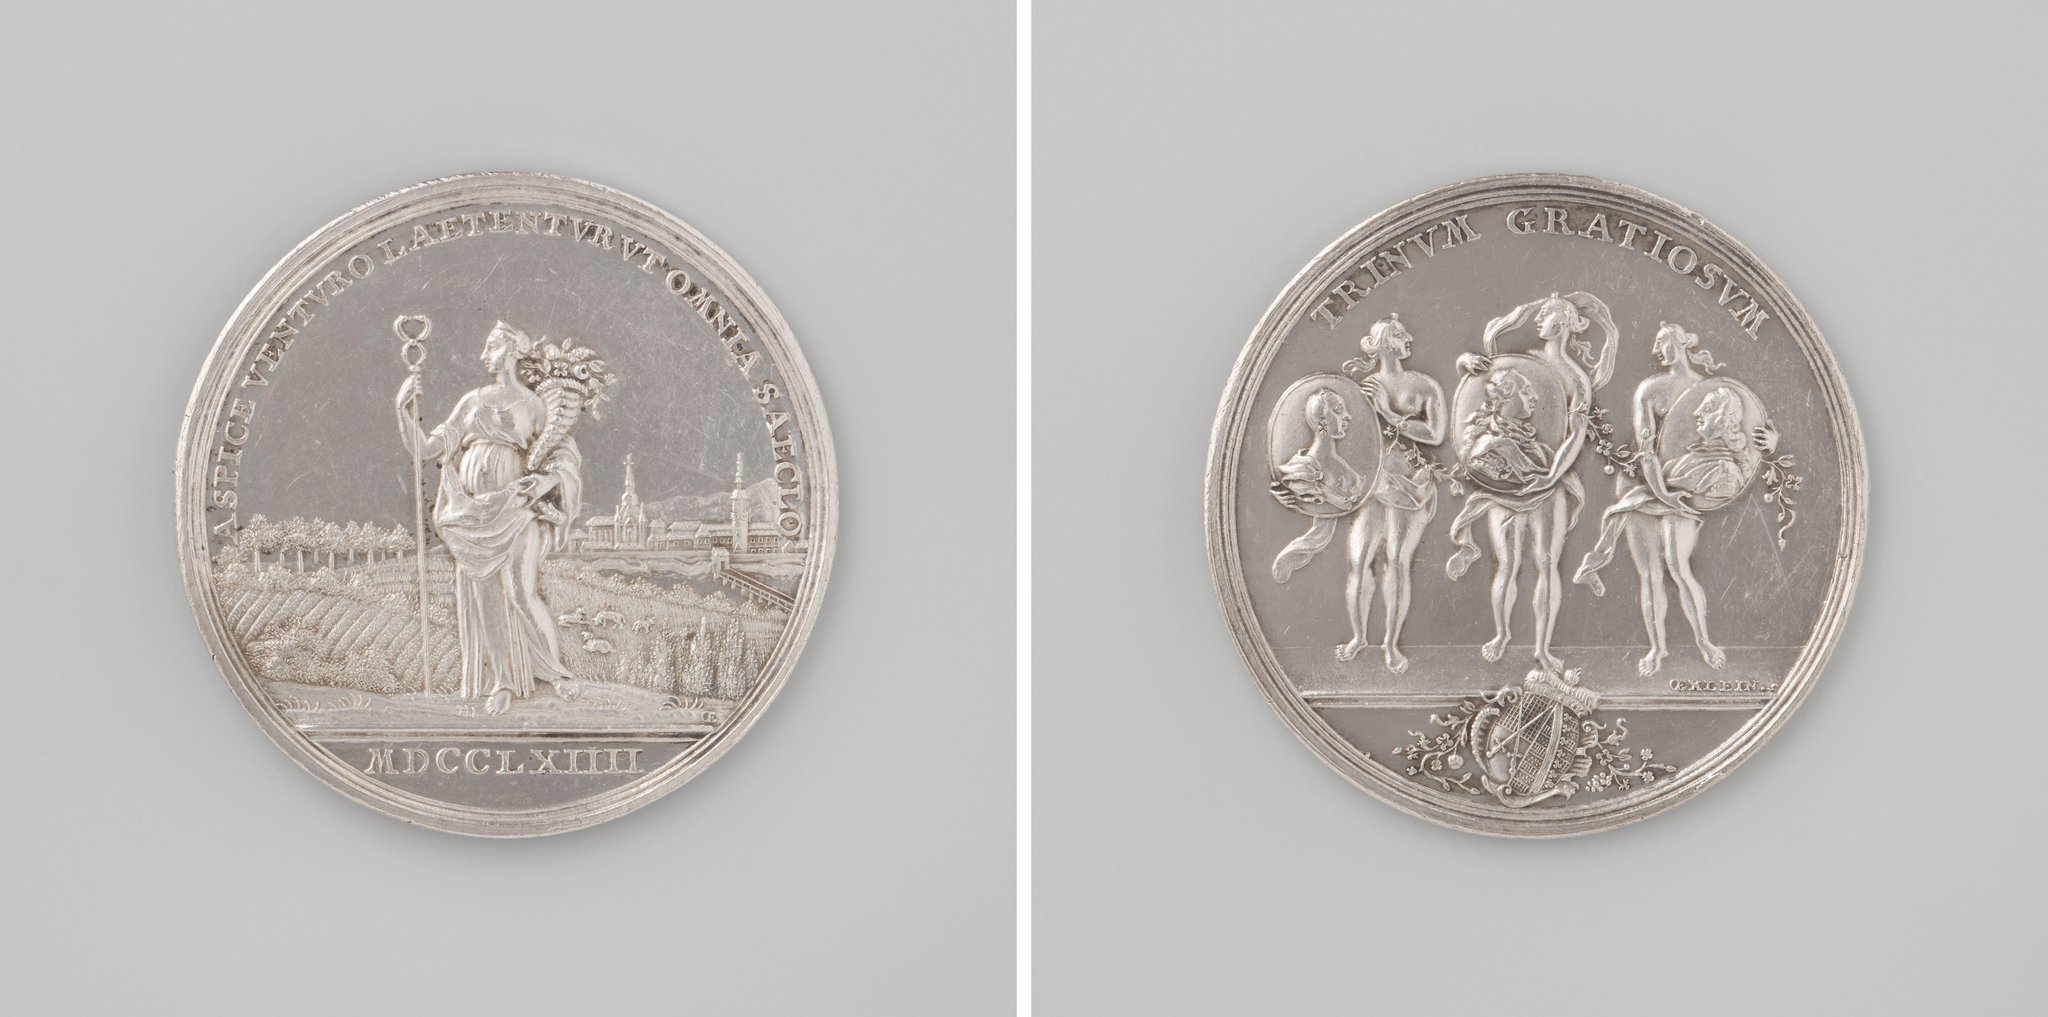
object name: history medal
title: Kroning van Jozef II tot Duits keizer te Frankfurt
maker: johann leonhard öxlein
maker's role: mintmaster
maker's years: 1715-1787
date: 1764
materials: silver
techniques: striking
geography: fulda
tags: vienna, jozef ii (duits keizer)